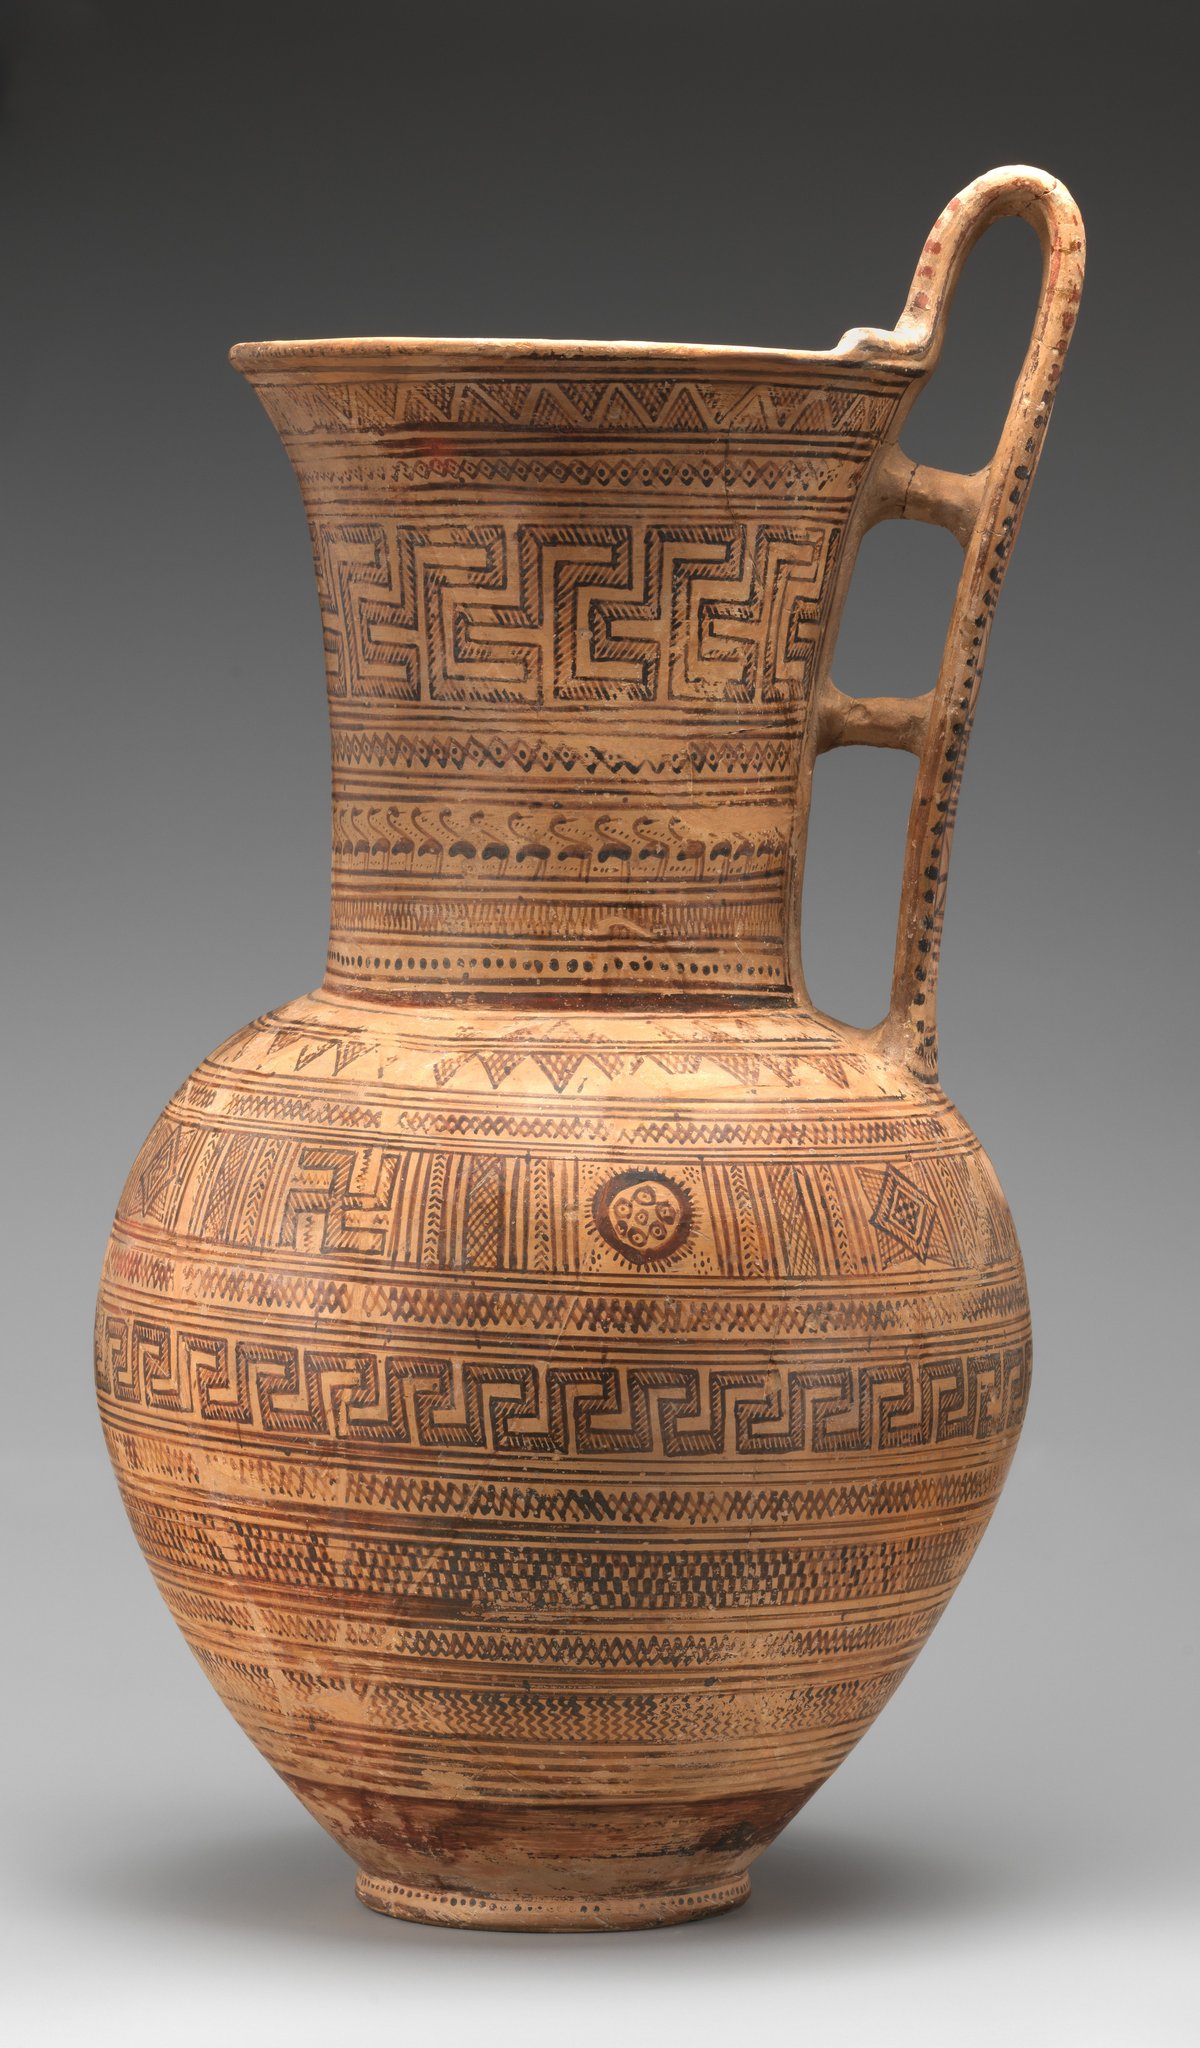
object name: oinochoe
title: Terracotta pitcher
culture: greek, attic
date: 750-725 BCE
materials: terracotta